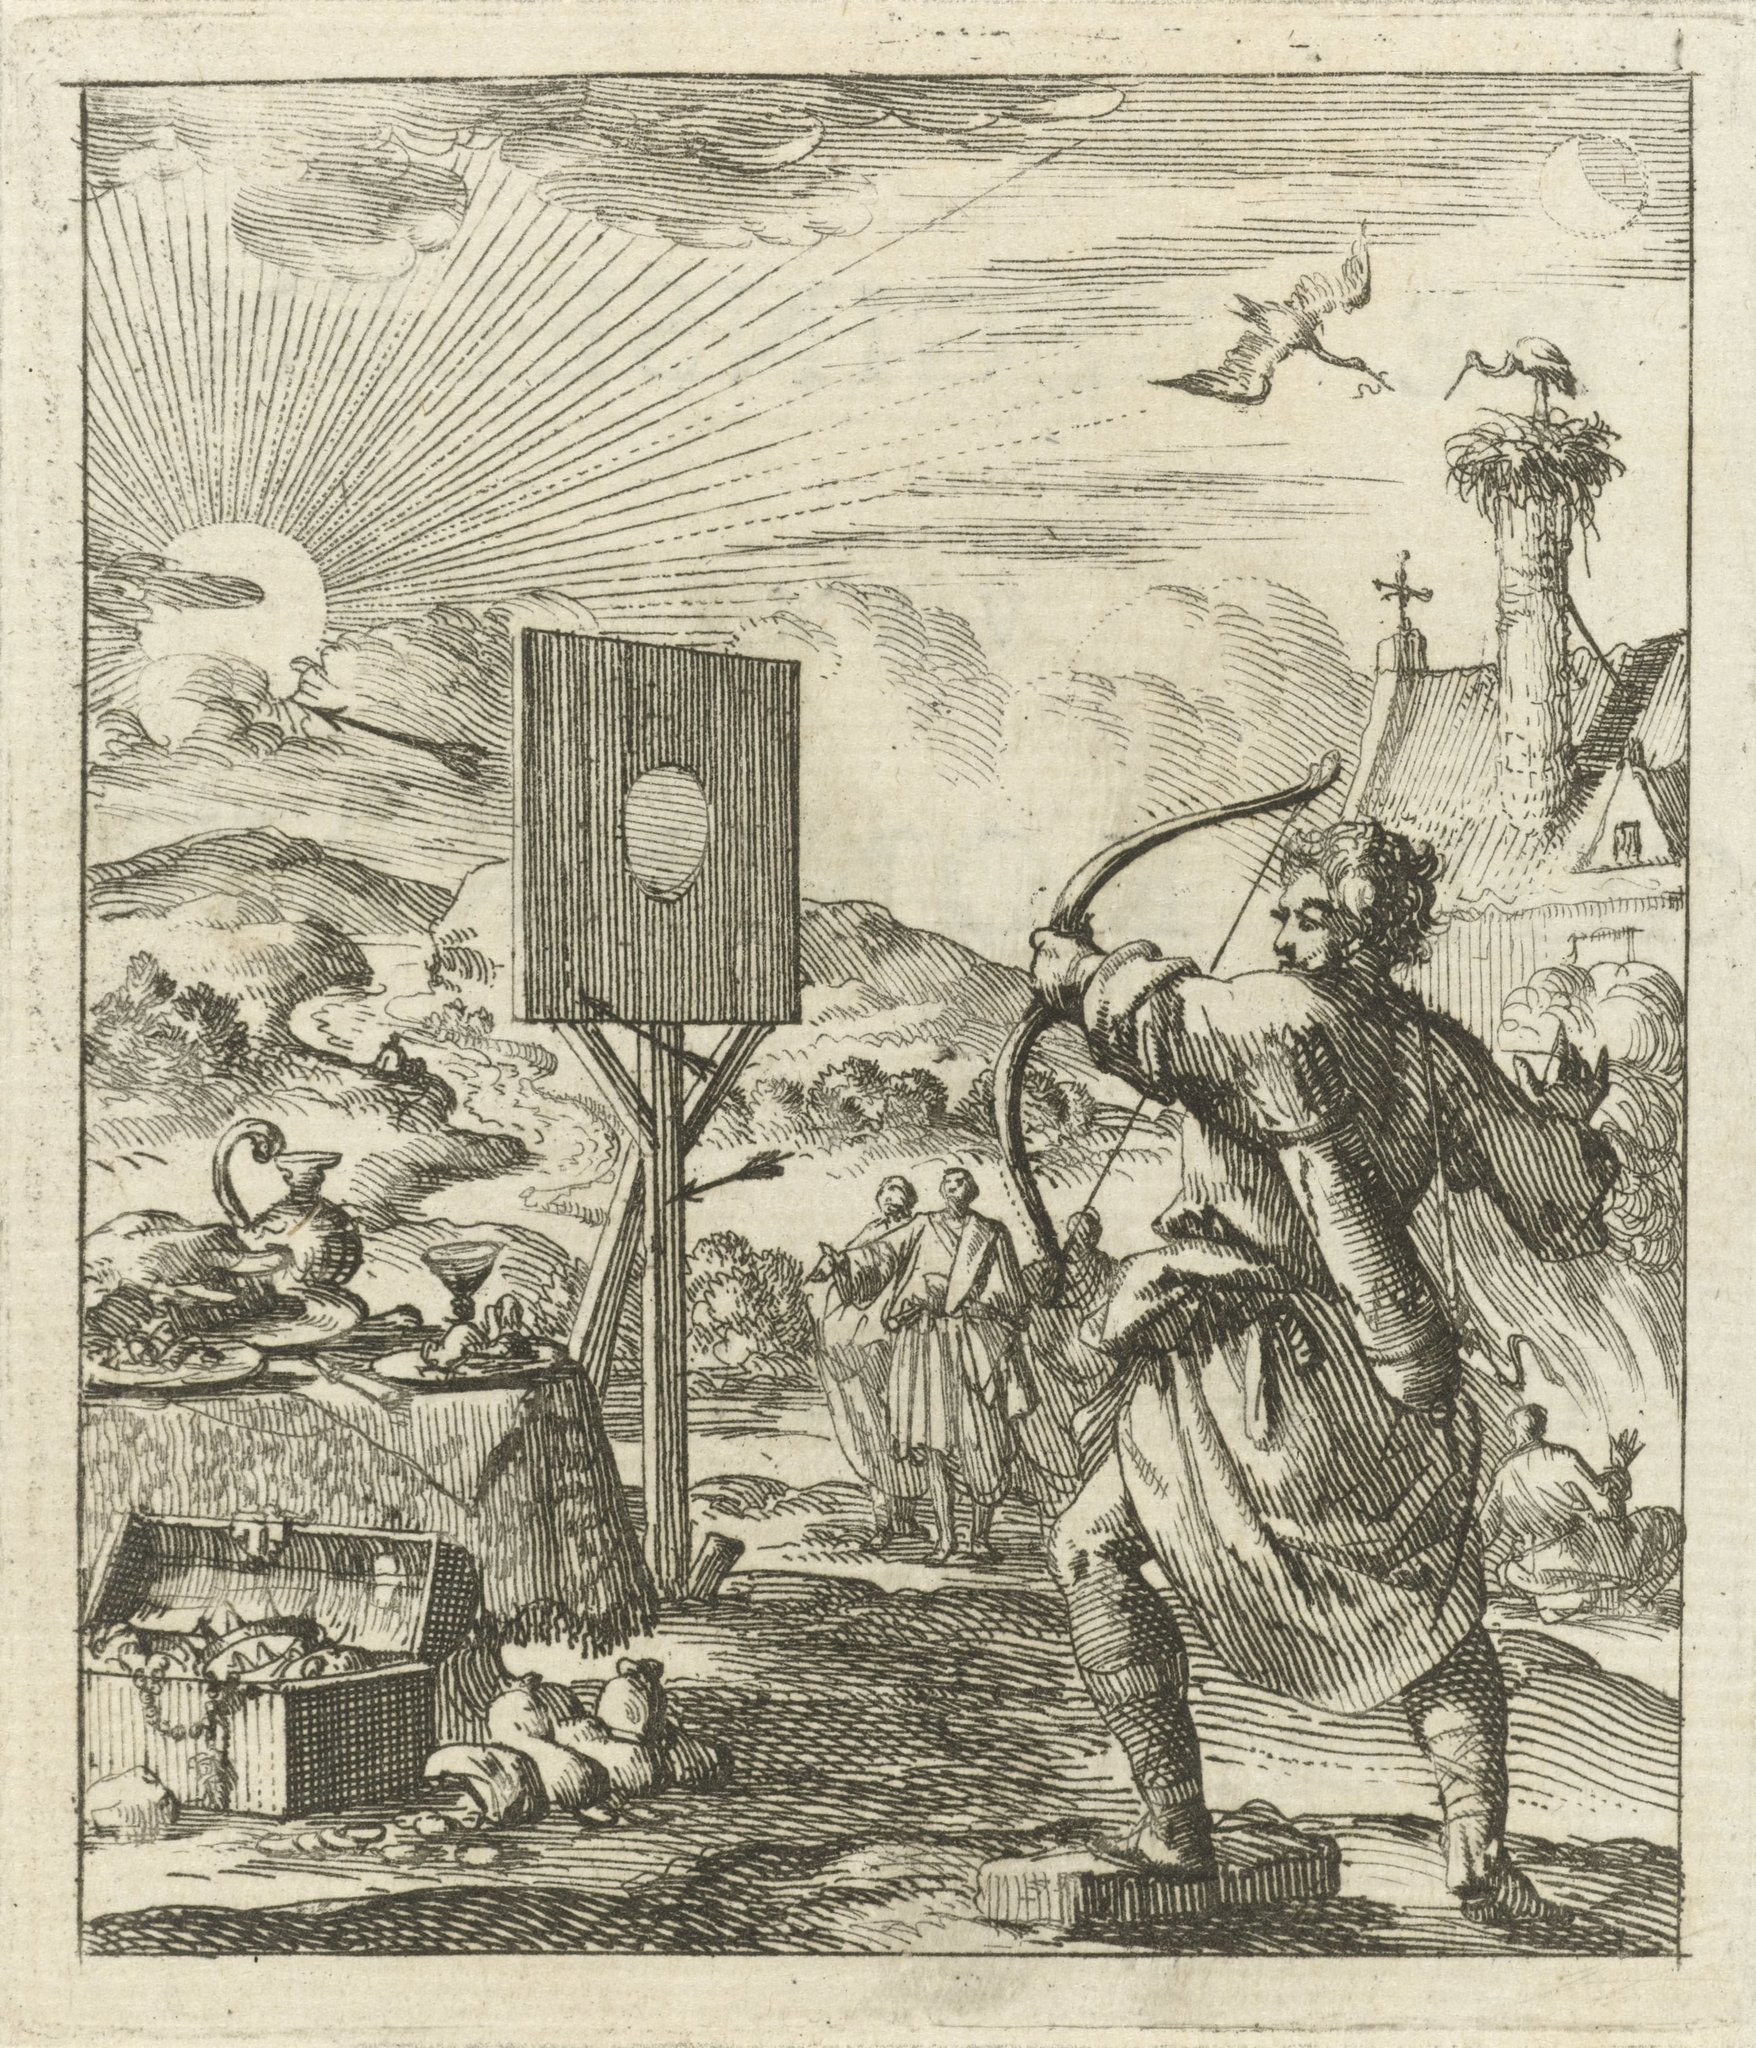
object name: print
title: 't Verlokte oog misleid den Boog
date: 1689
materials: paper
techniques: etching, letterpress printing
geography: amsterdam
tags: shooting with bow and arrow, archery (~ games of skill)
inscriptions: collector's mark: Lugt 2228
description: Illustratie uit: Huygen, Pieter. De beginselen van Gods koninkryk in den mensch uitgedrukt in zinnebeelden. Amsterdam: wed. Arentsz. Pieter (II), 1689, p. 2.